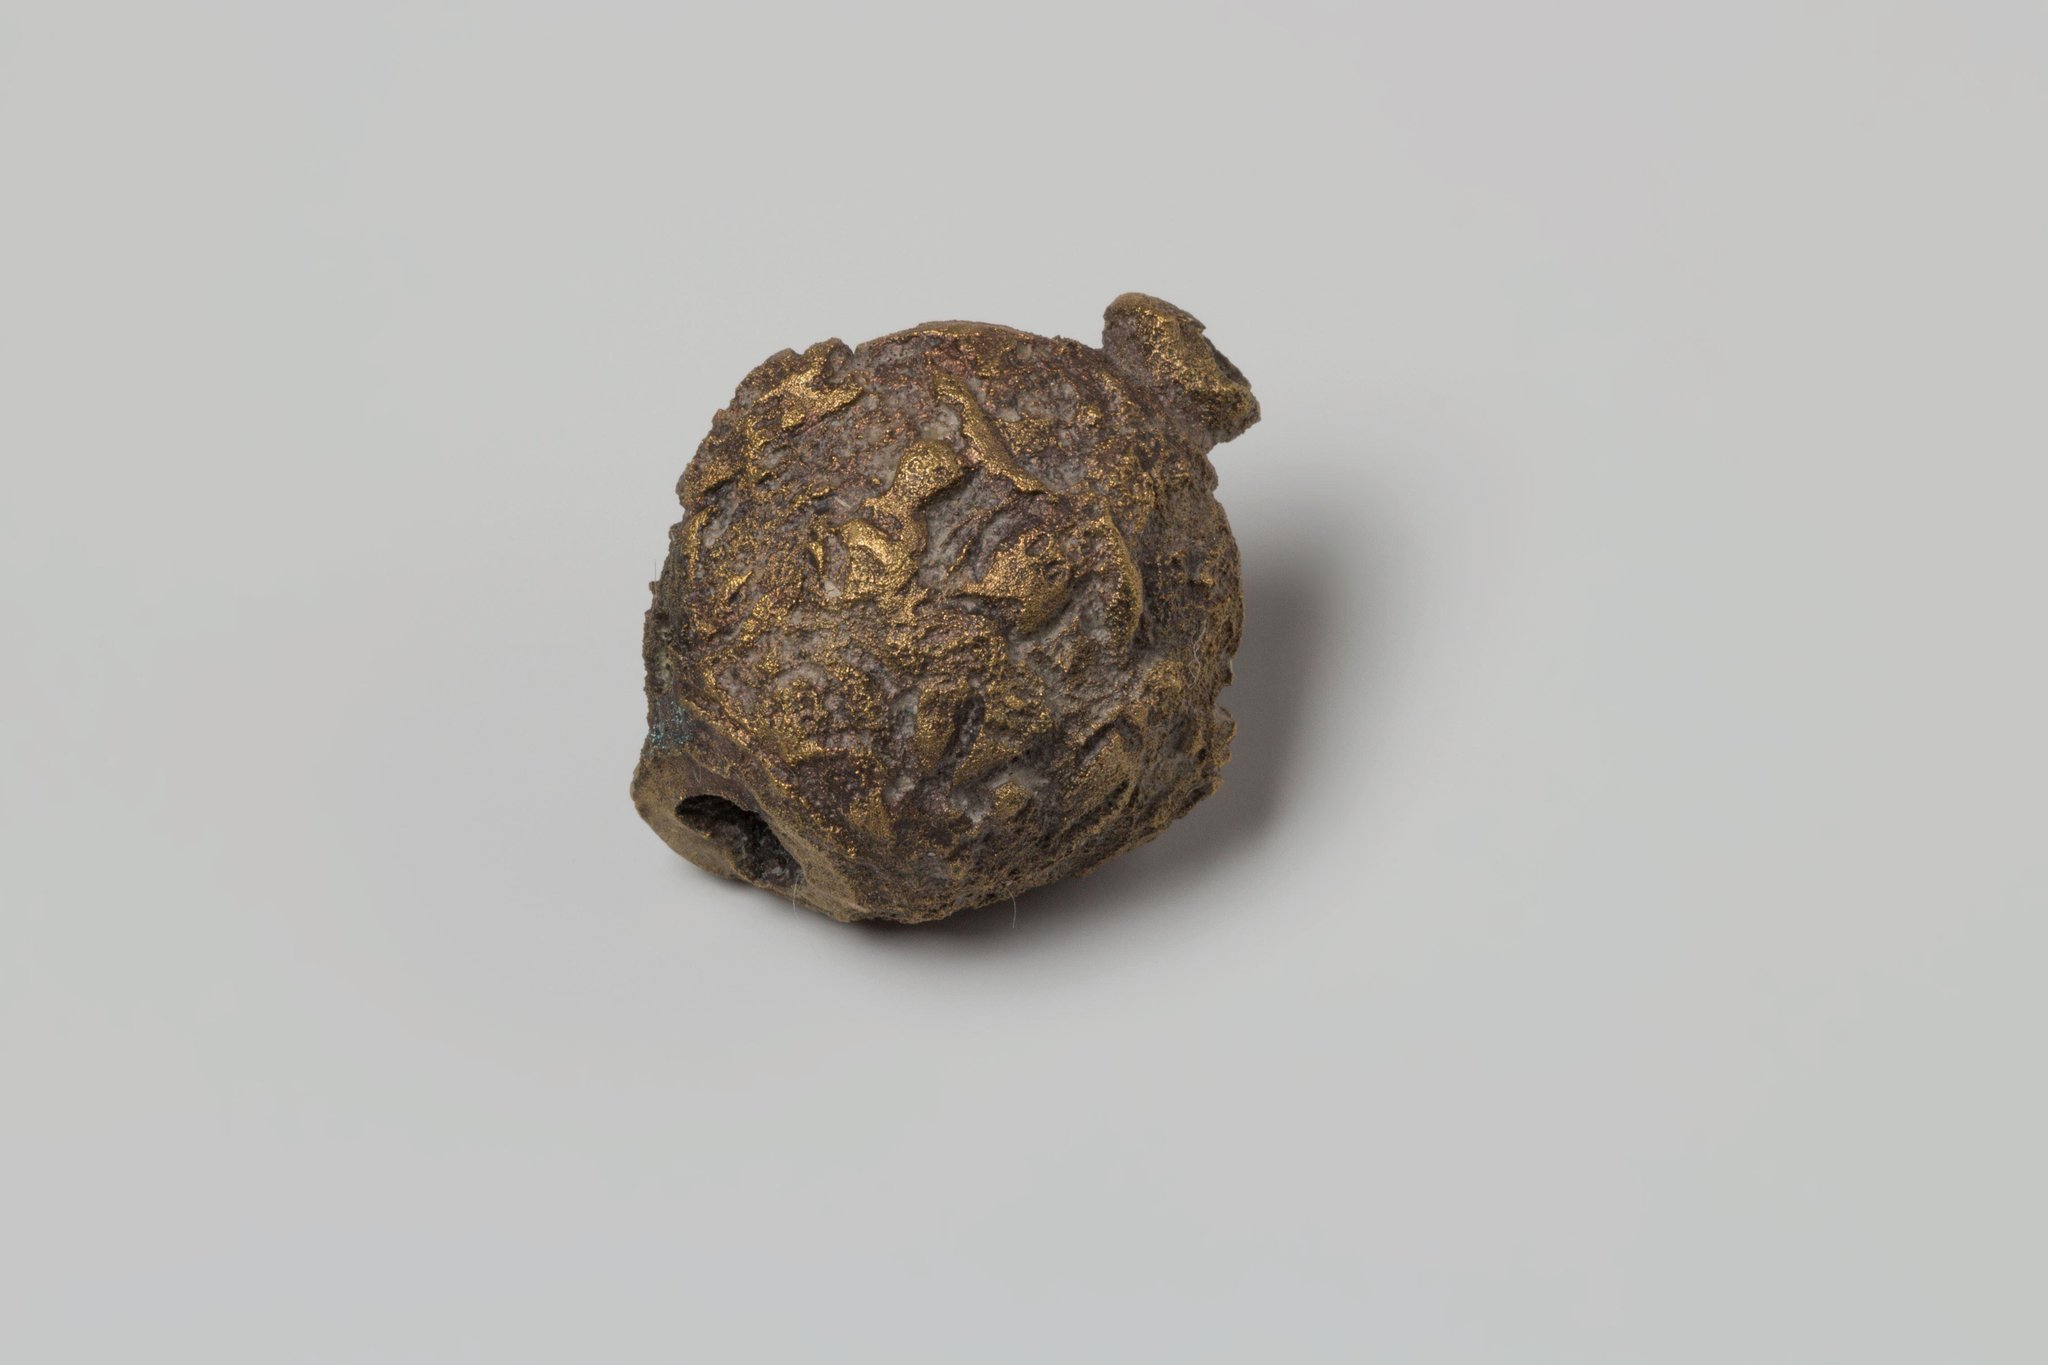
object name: zwaardknop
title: Zwaardknop of pommel van een degengevest uit het wrak van de in 1735 vergane Oost-Indiëvaarder 't Vliegend Hart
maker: Anonymous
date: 1700-1735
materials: copper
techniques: engraving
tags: 't vliegend hart (schip), verenigde oostindische compagnie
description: De ovale pommel of zwaaardknop is van koper en toont aan twee zijden een iconografische voorstelling. Voorzijde: drie figuren, allen naar links gewend. De persoon in het midden lijkt ergens op te zitten en maakt een beweging alsof deze pijl en boog schiet. Achterzijde: in het midden figuur, zittend, met hand onder het hoofd ter ondersteuning. Aan de zijkant van de knop twee maskers. De knop is boven het gevest afgebroken; ook de bovenzijde is beschadigd. Hilt.